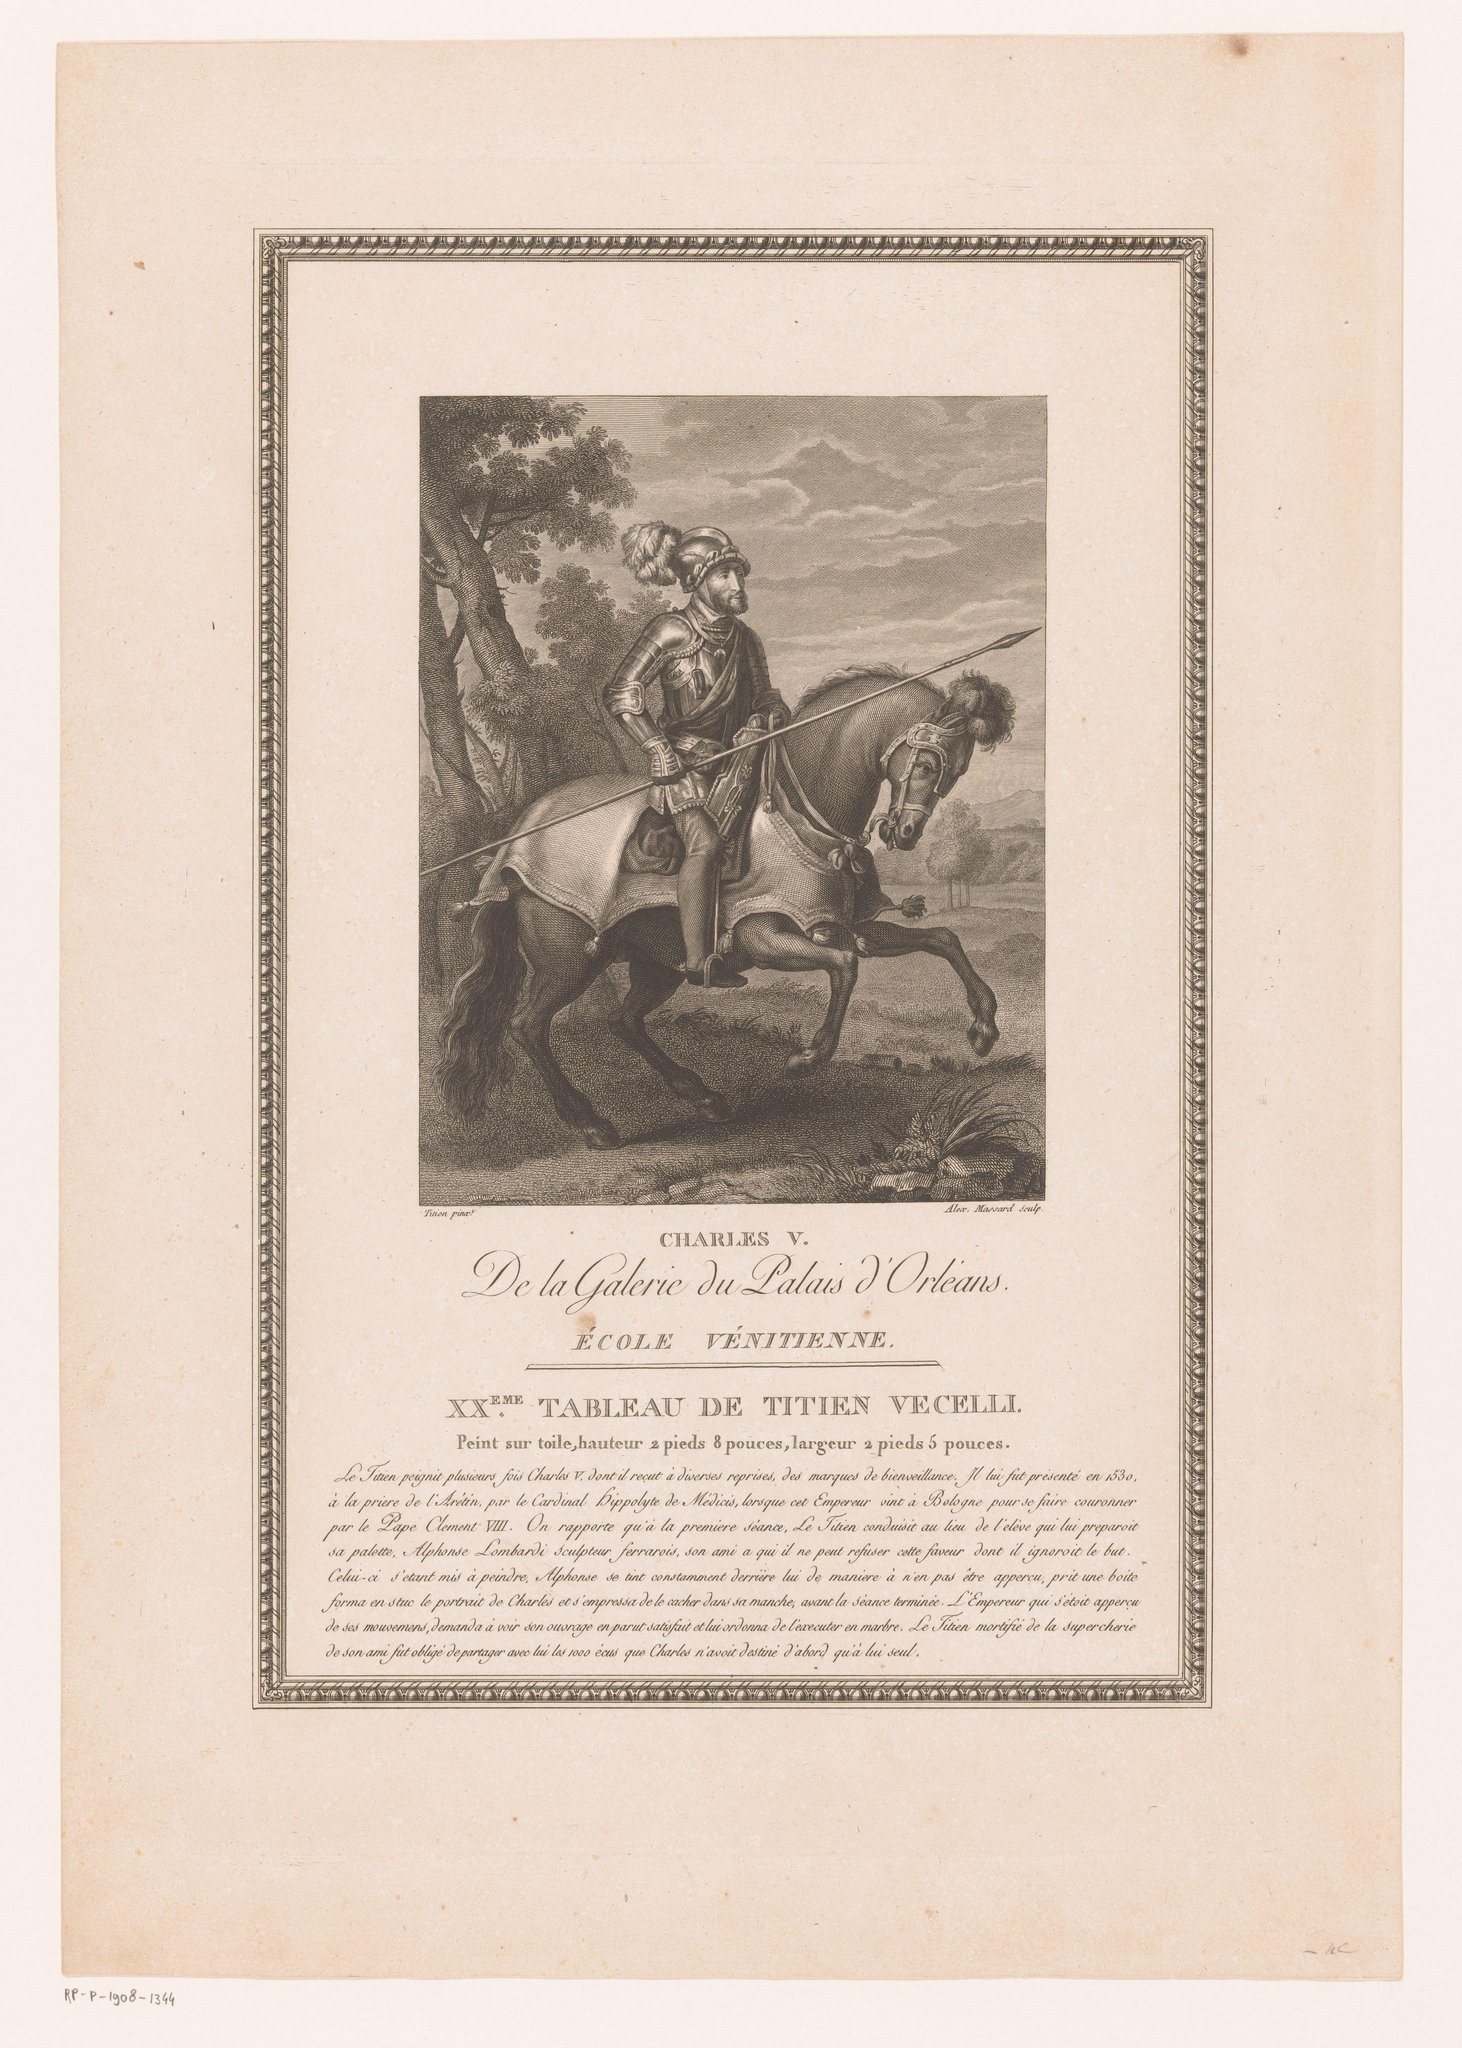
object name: print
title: Schilderijen uit de collectie van de Hertog van Orléans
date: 1787-1808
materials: paper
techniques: engraving, etching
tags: ghent, charles v (holy roman emperor and king of spain), historical persons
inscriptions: collector's mark: Lugt 2228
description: Onderdeel van een serie van 354 prenten naar schilderijen uit de collectie van de Hertog van Orléans, getiteld: La Galerie du Palais Royal, uitgebracht tussen 1786 en 1808. De serie werd uitgegeven door Jacques Couché die het project samen met Jacques Bouillard leidde.